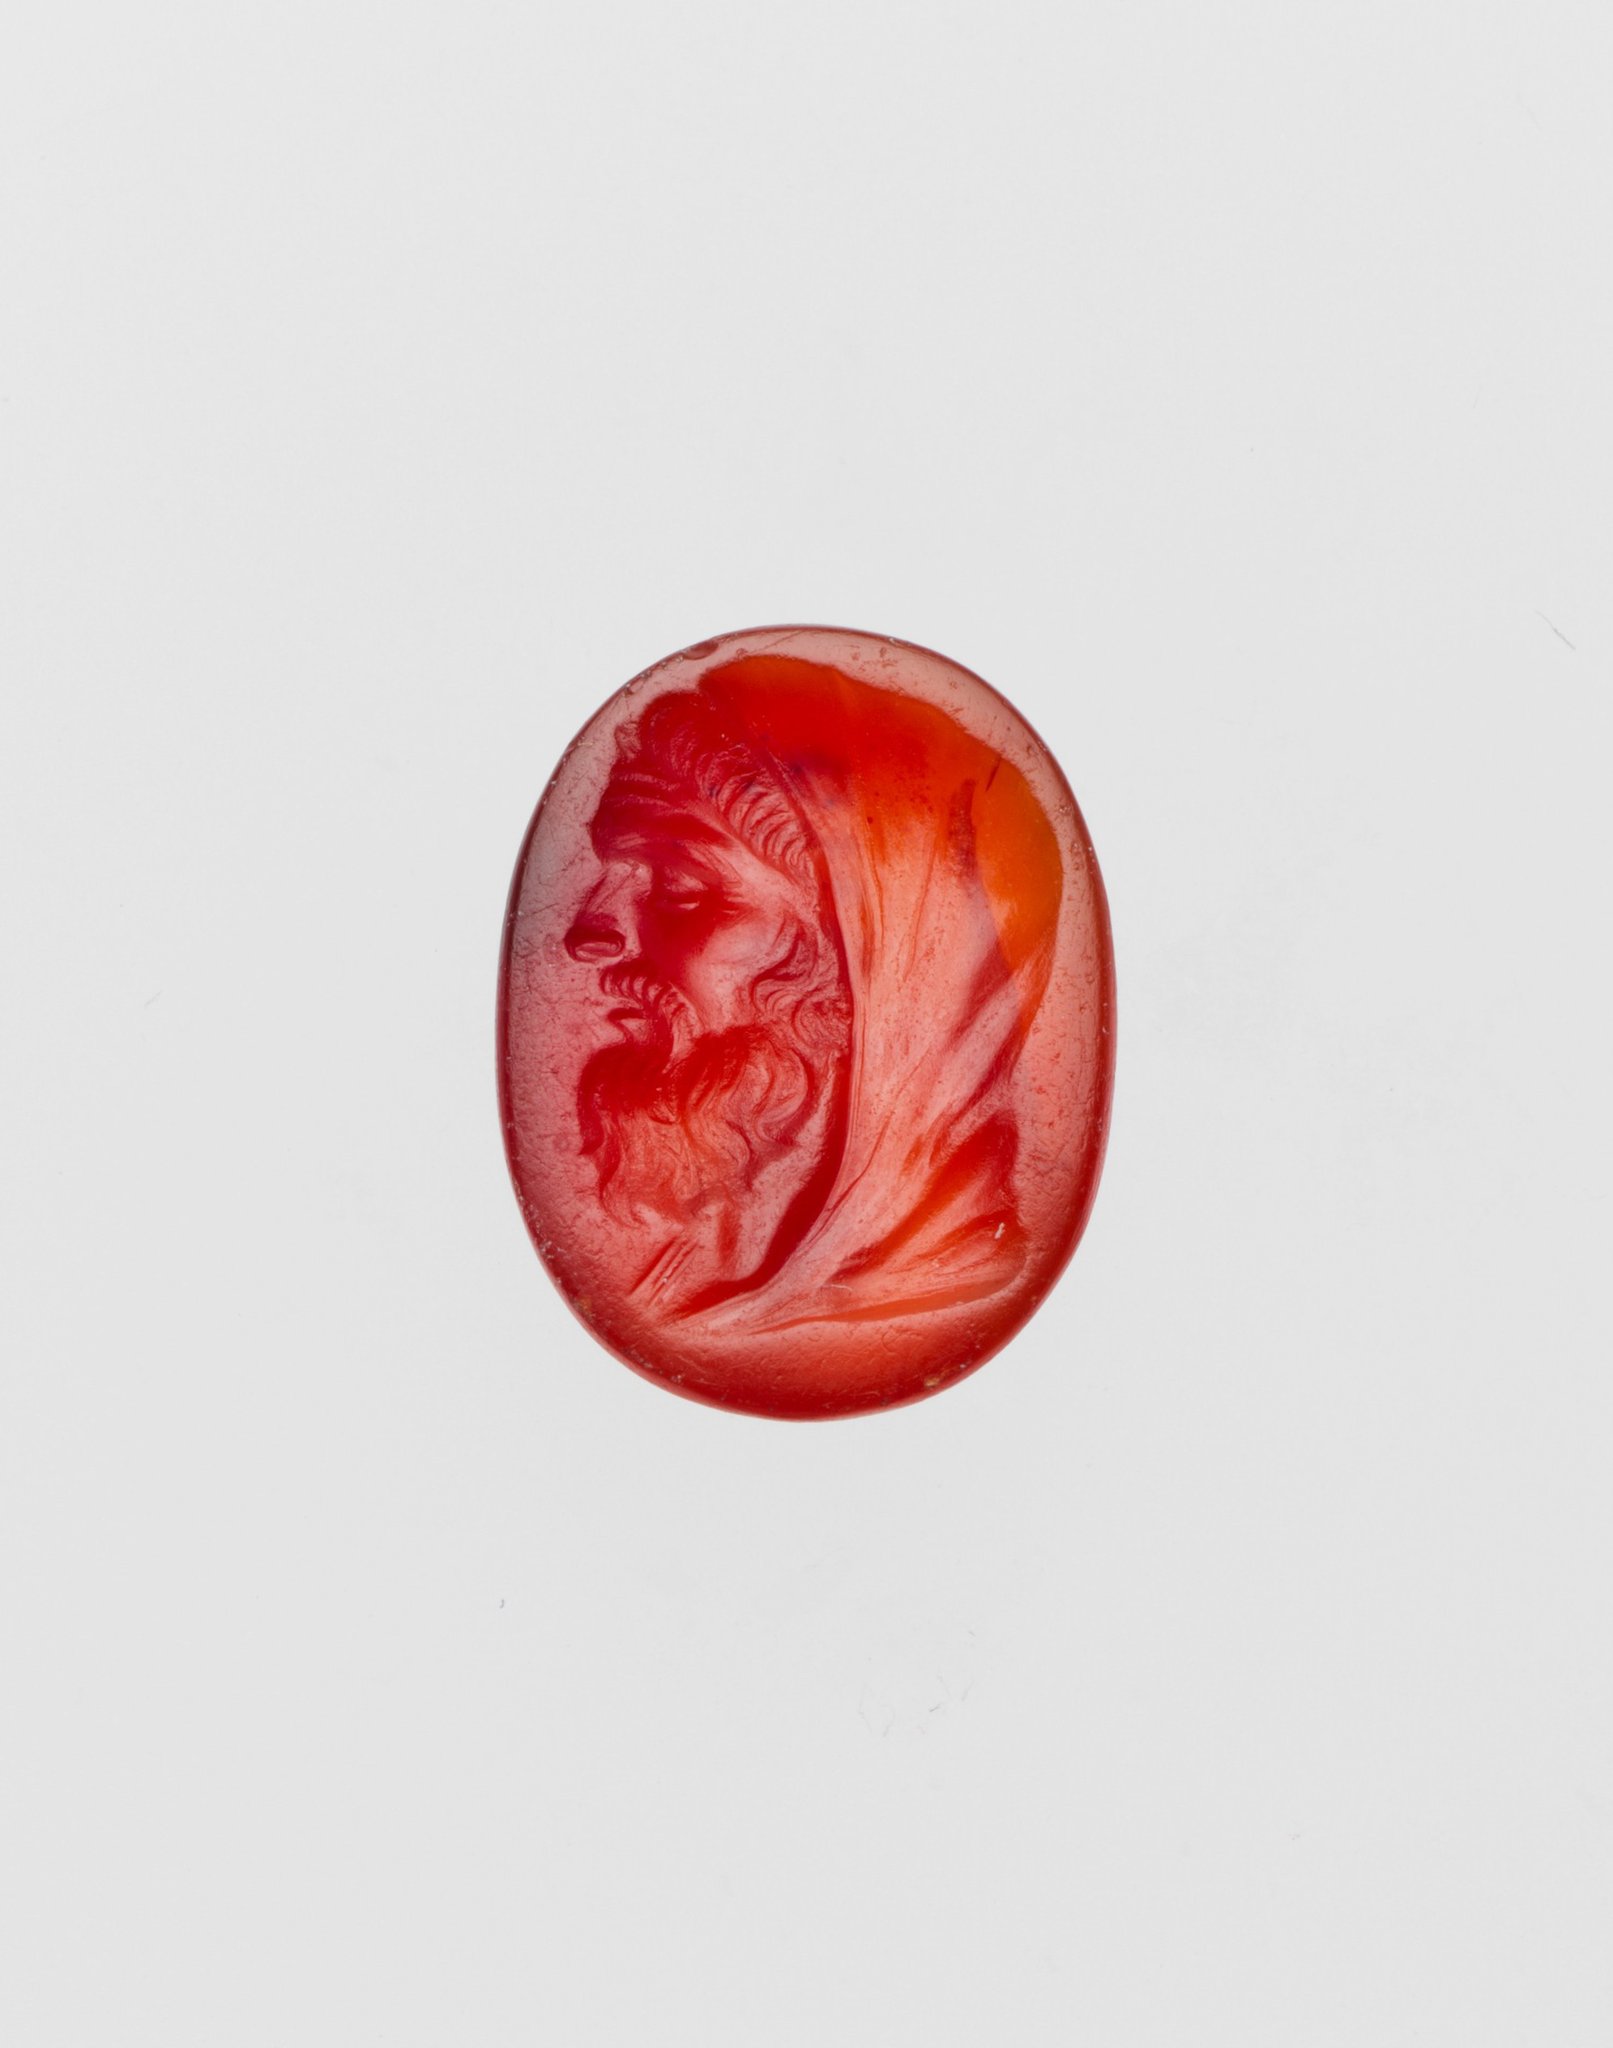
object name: intaglio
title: Carnelian ring stone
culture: roman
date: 100 BCE-300 CE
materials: gemstone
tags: men,profiles